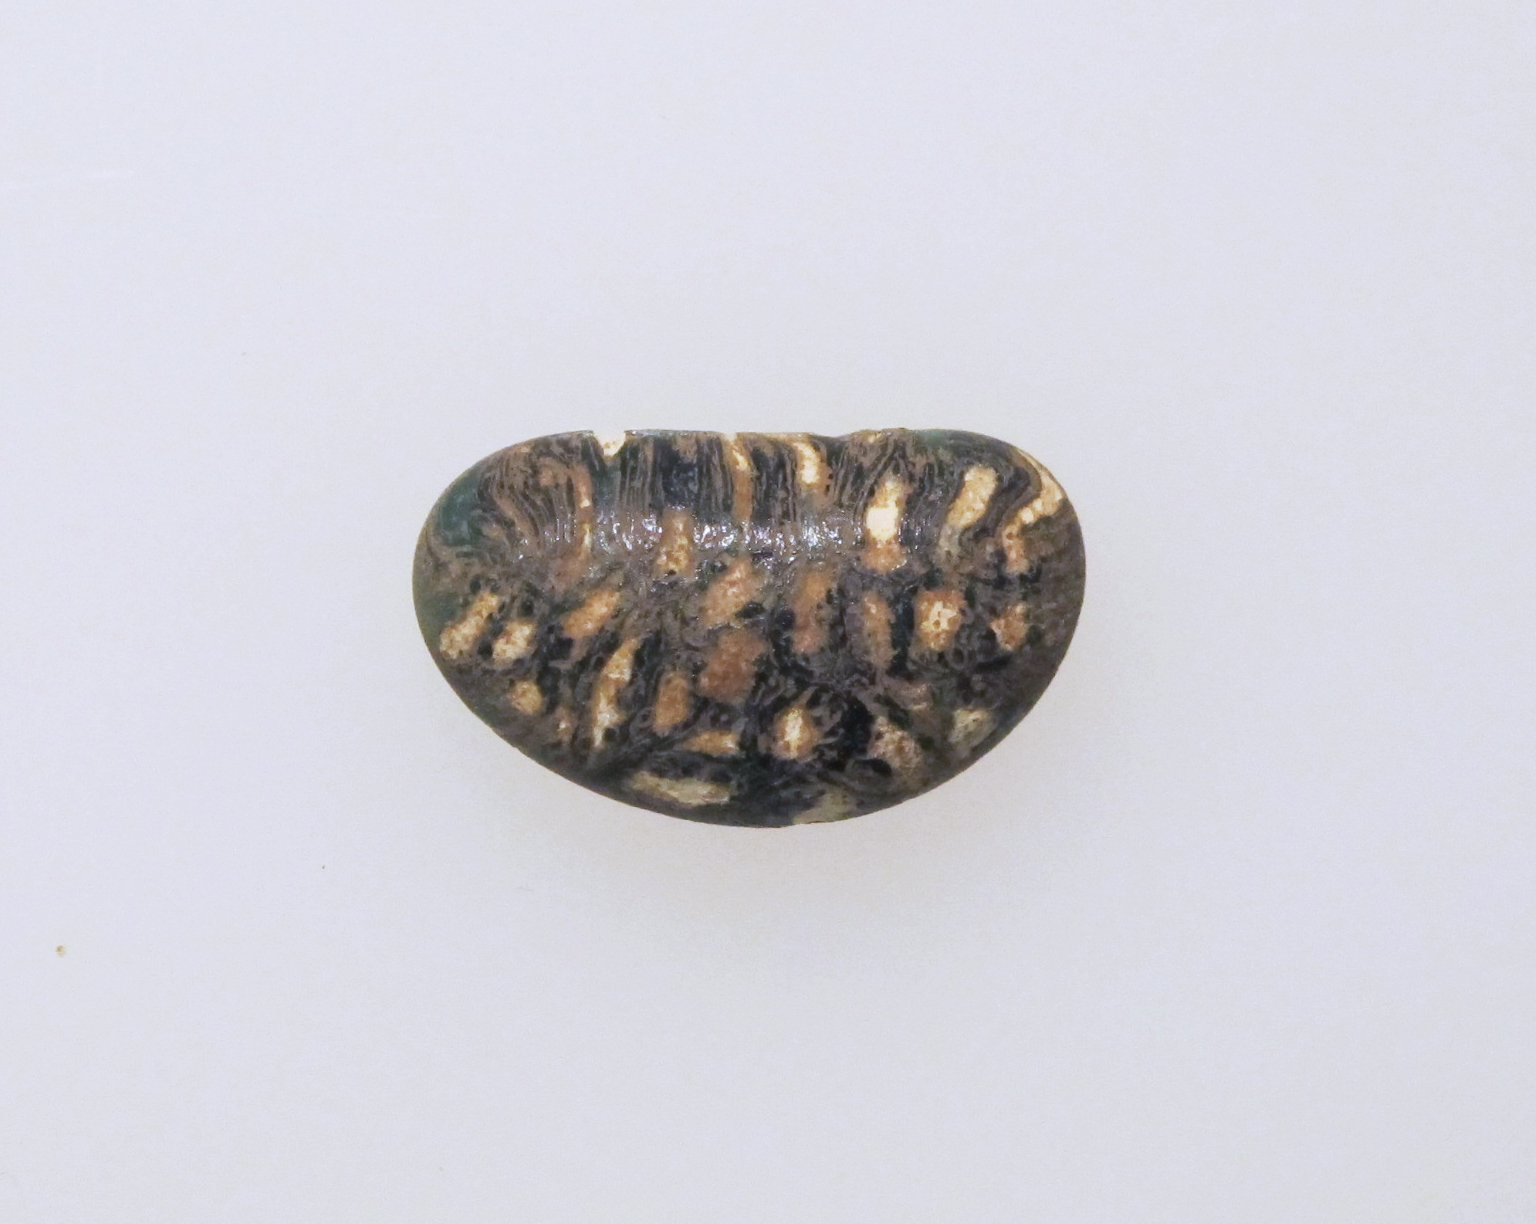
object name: pinhead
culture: roman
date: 670 BCE-330 CE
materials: glass